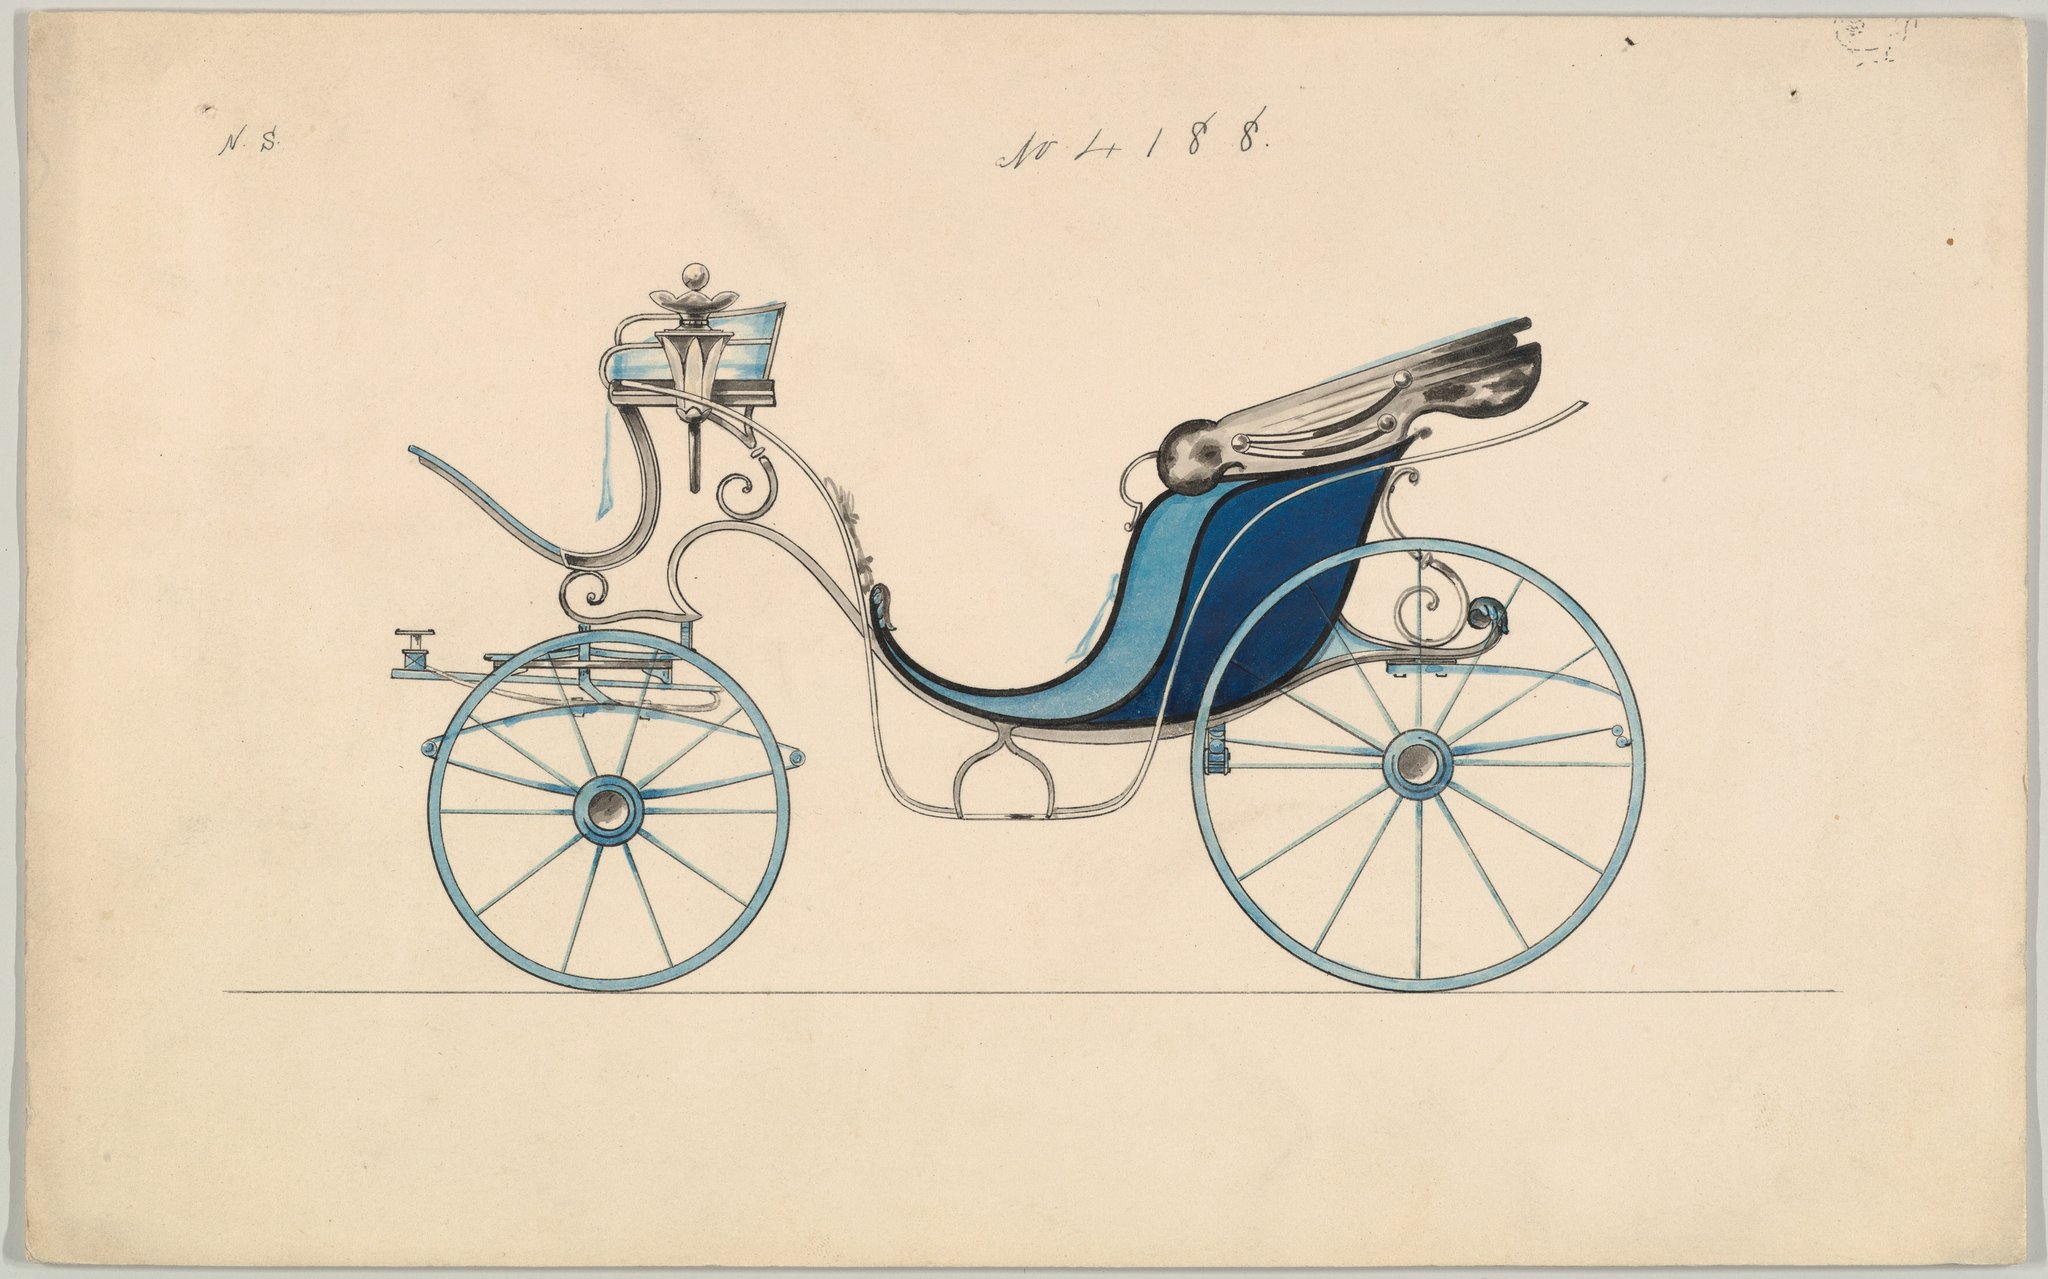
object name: drawing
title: Design for Cabriolet or Victoria, no. 4188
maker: brewster & co.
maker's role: manufacturer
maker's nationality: american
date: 1892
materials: gouache, ink, watercolor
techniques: pen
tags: carriages